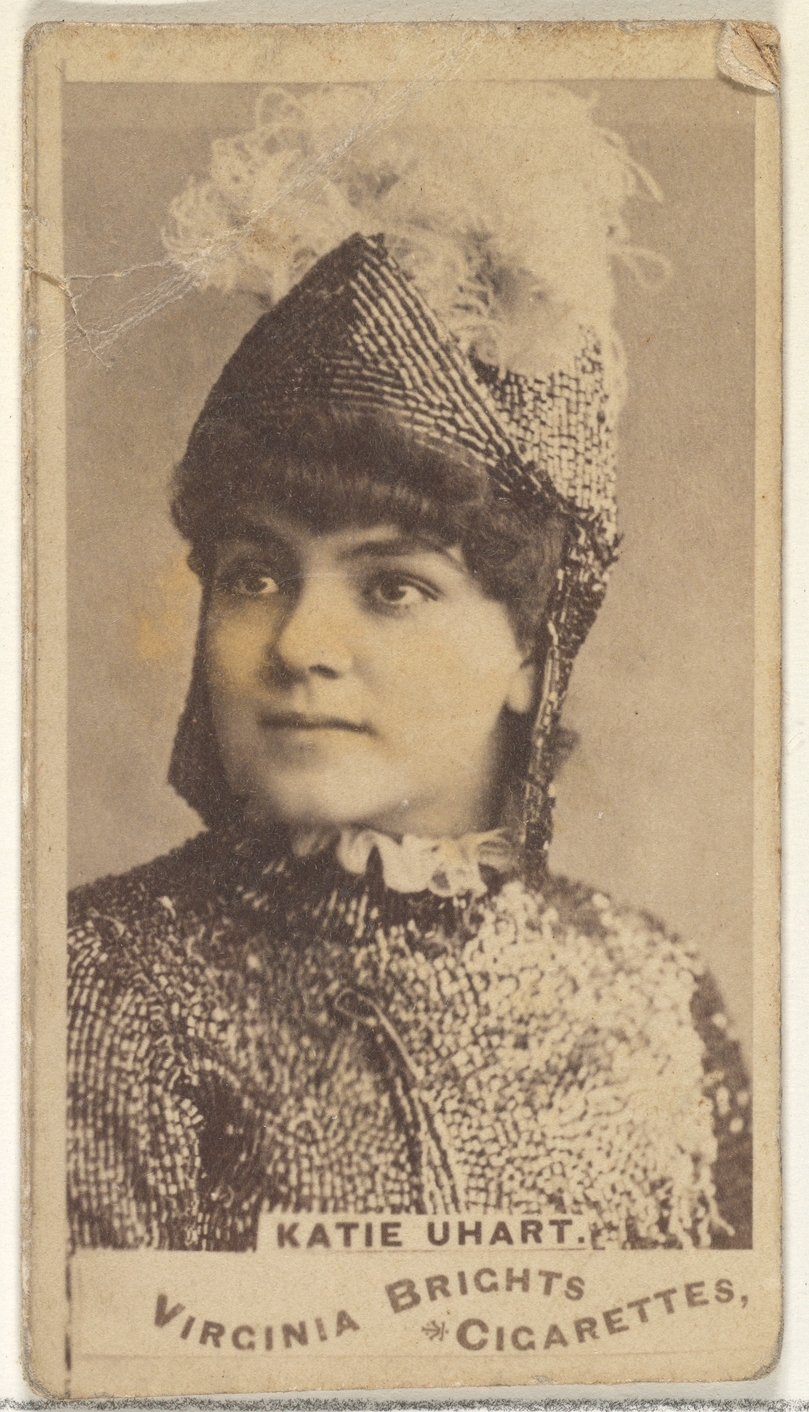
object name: photograph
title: Katie Uhart, from the Actors and Actresses series (N45, Type 1) for Virginia Brights Cigarettes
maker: allen & ginter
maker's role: publisher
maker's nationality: american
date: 1888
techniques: albumen silver print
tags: portraits,women,actresses